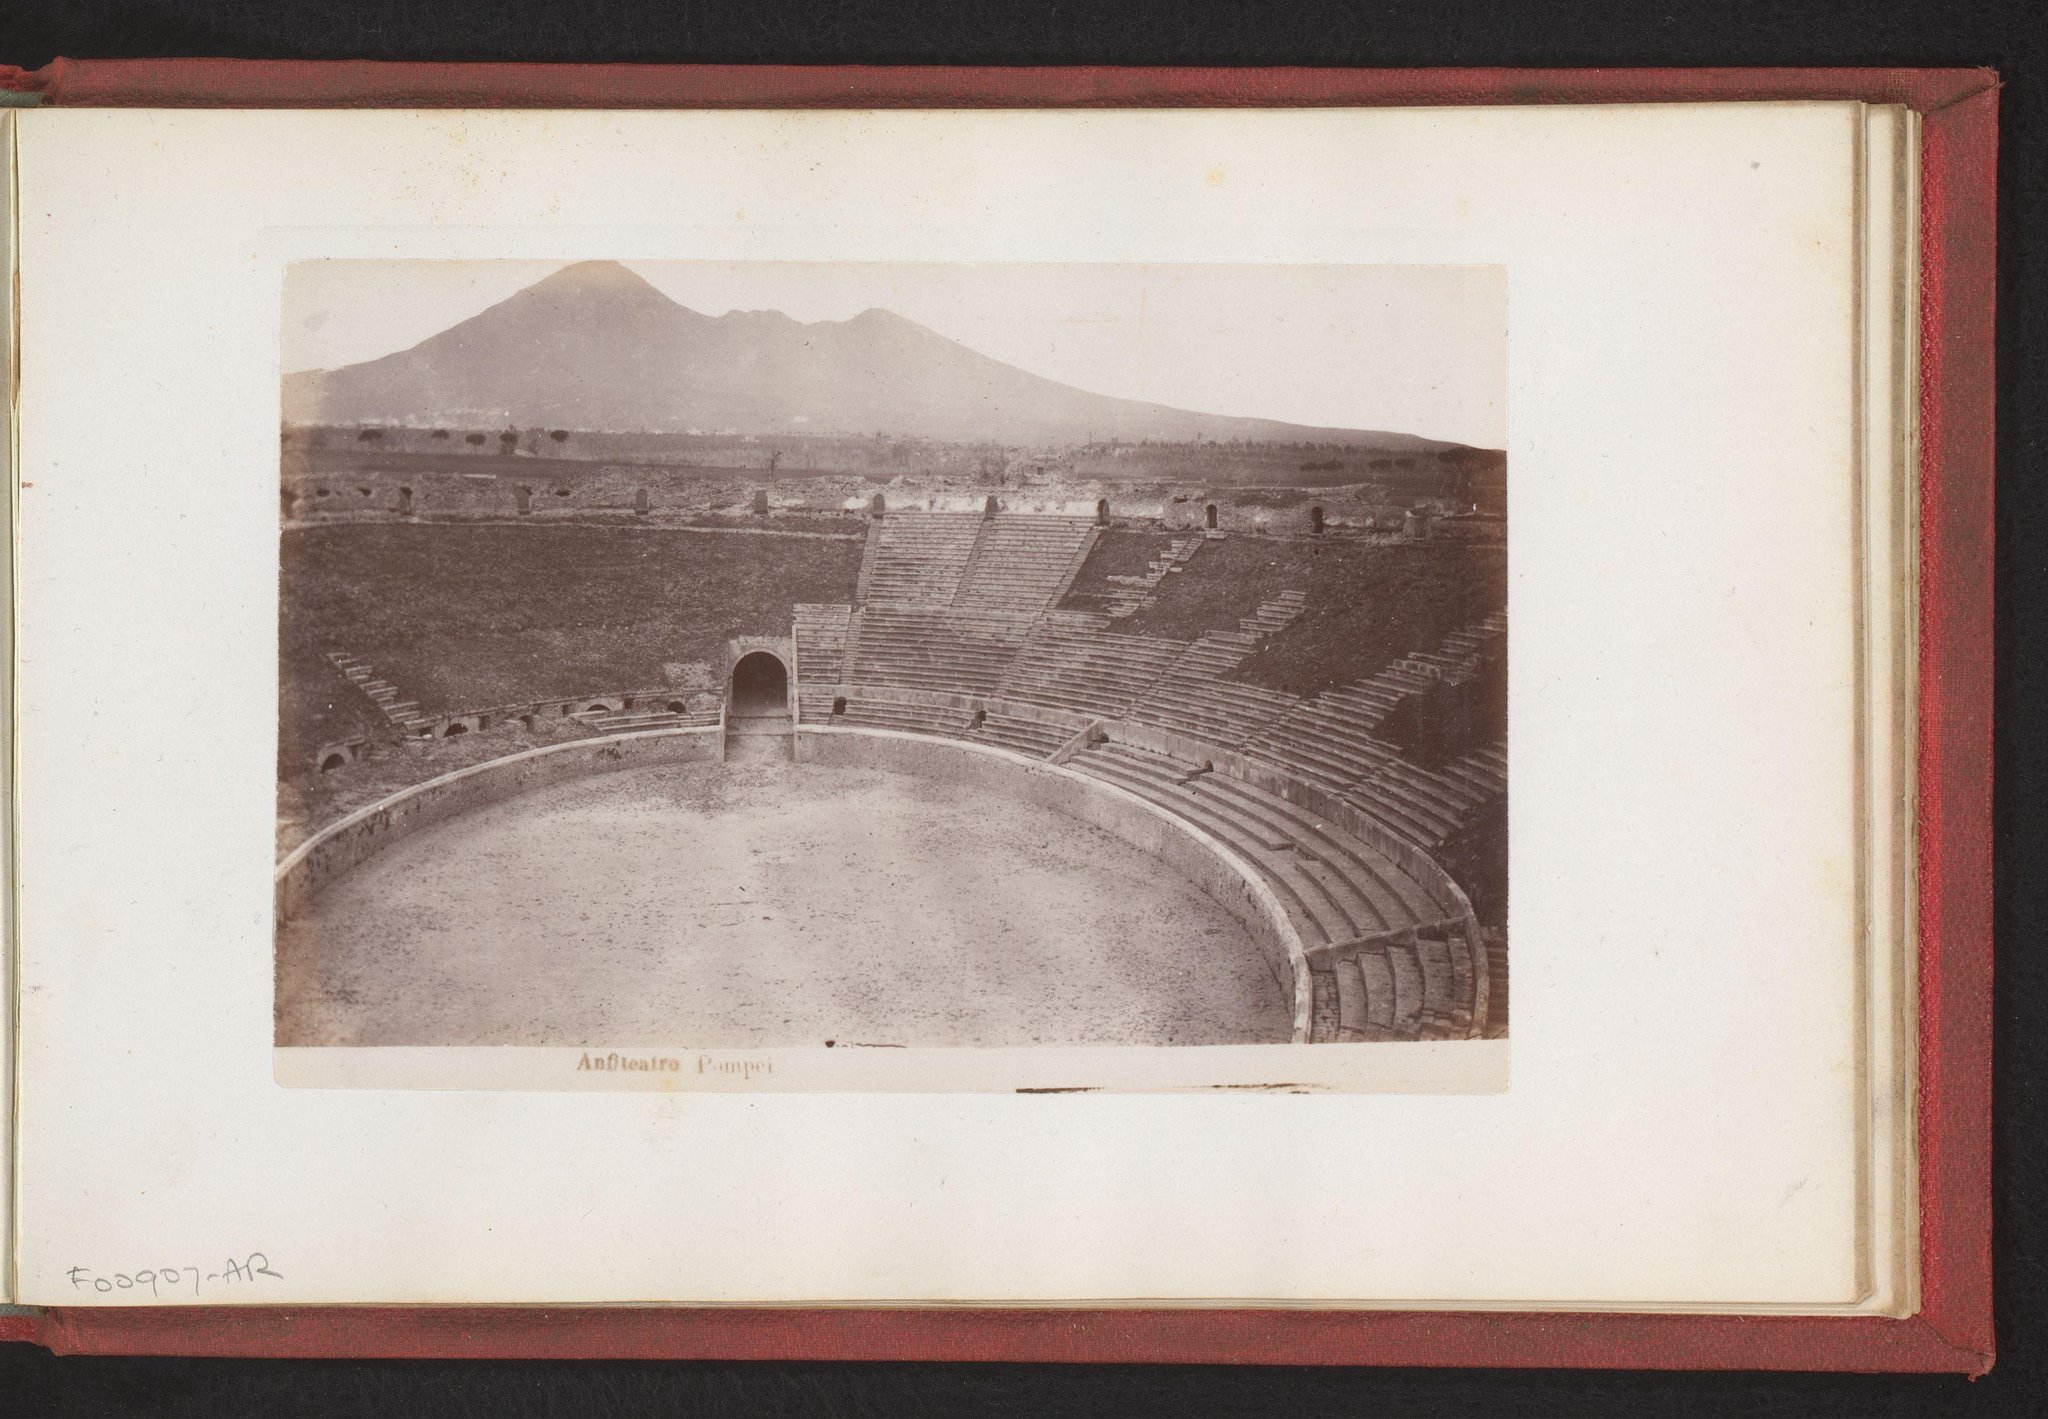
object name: album leaf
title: Amfitheater te Pompeï met op de achtergrond de Vesuvius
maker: Anonymous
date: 1860-1900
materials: photographic support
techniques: albumen print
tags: amphitheatre, volcano, pompeii